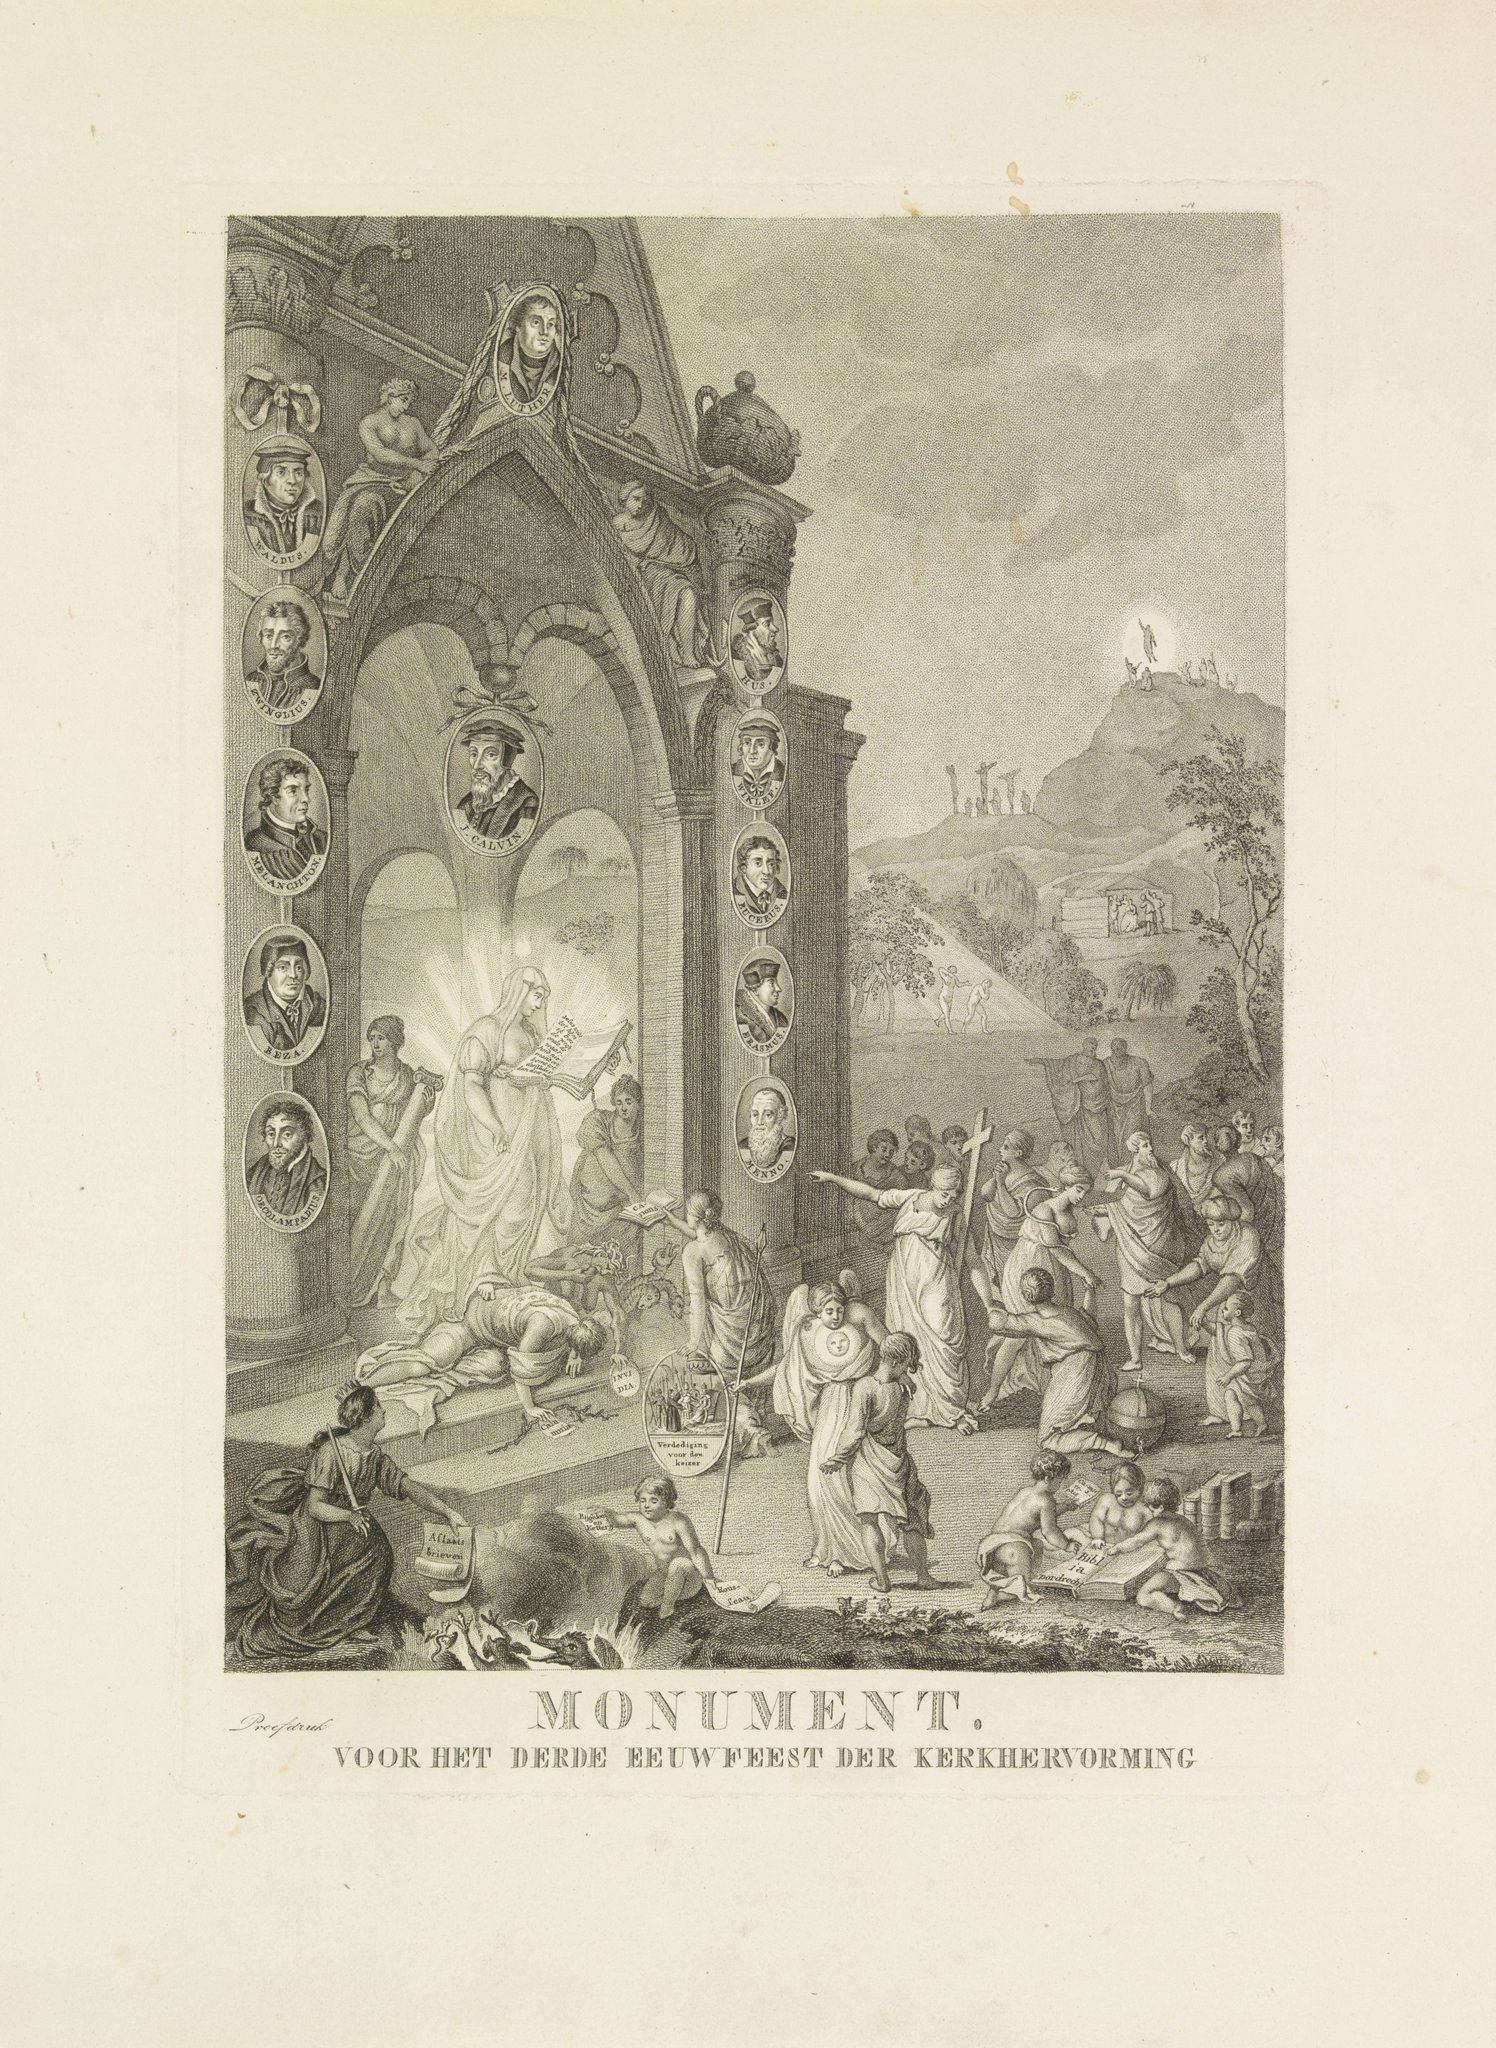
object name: print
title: Monument. Voor het Derde Eeuwfeest der Kerkhervorming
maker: Anonymous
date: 1724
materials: paper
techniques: engraving, etching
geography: netherlands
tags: rotterdam, desiderius erasmus, theodorus beza, clergyman, priest, martin luther, fortitude, 'fortitudo' ~ one of the four cardinal virtues, faith, 'fides'; 'fede', 'fede catholica', 'fede christiana', 'fede christiana catholica' (ripa) ~ one of the three theological virtues, hope, 'spes'; 'speranza divina e certa' (ripa) ~ one of the three theological virtues, envy; 'invidia' (ripa) ~ personification of one of the seven deadly sins, calumny, detraction; 'biasimo vitioso', 'calunnia', 'detrattione', 'maledicenza' (ripa), allegorical representations ~ religion; 'religione', 'religione de ss. mauritio e lazaro', 'religione vera christiana' (ripa), monument, statue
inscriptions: collector's mark: Lugt 2228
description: Monument voor het derde eeuwfeest van de Hervorming, 1517-1817. Allegorische voorstelling met links de ingang tot een tempel waartegen medaillons met portretten van kerkhervormers zijn gehangen. Centraal bovenaan het portret van Martin Luther, in het midden Calvijn. In de deur van de tempel staat de Godsdienst die de Afgunst en de Laster vertreedt, hierbij ook de Standvastigheid en de Hoop. Links verbrant een gekroonde vrouw aflaatbrieven en andere pamfletten (o.a. van Rousseau) in de vuur van de hel. Voor de tempel wijzen deugden als Geloof en Hoop de gelovigen in de richting van de tempel. Op de achtergrond scènes uit de Bijbel. Bij de prent behoort een afzonderlijke verklaring.